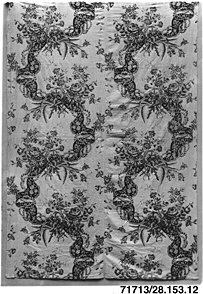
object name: piece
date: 1767-1833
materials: cotton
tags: flowers,leaves